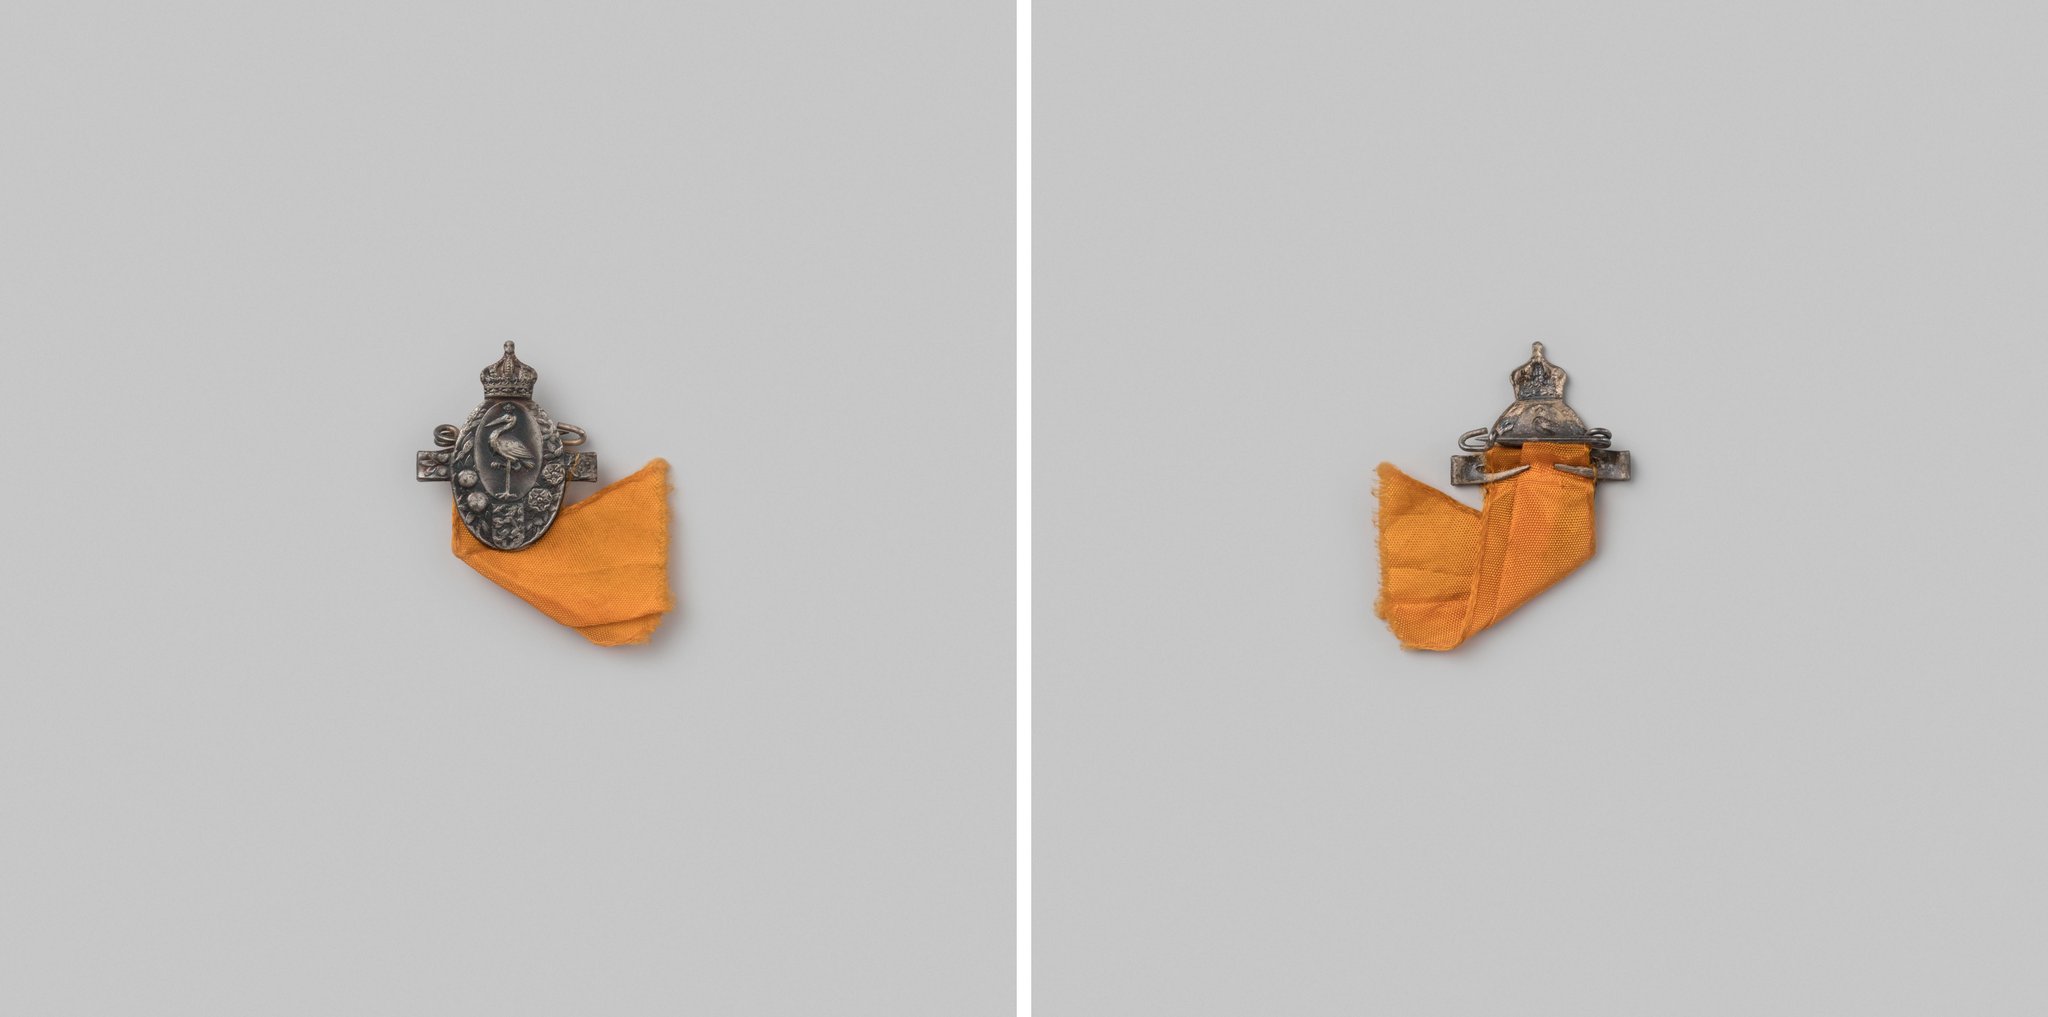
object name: insignia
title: Oranjeteken van de stad 's-Gravenhage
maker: Anonymous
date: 1900-1940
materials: silver, textile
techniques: sewing, striking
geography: the hague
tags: the hague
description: Zilveren eenzijdige, ovale plaquette onder kroon, met aan beide zijde twee uitstekels, die achter penning teruggebogen zijn en waar oranje lint door is gestoken. Voorzijde: op een poot staande, gekroonde ooievaar, boven wapenschild binnen rand van vruchtdragende oranjetakken en rozen onder kroon. Keerzijde: blanco. Achterzijde is een speld gesoldeerd.